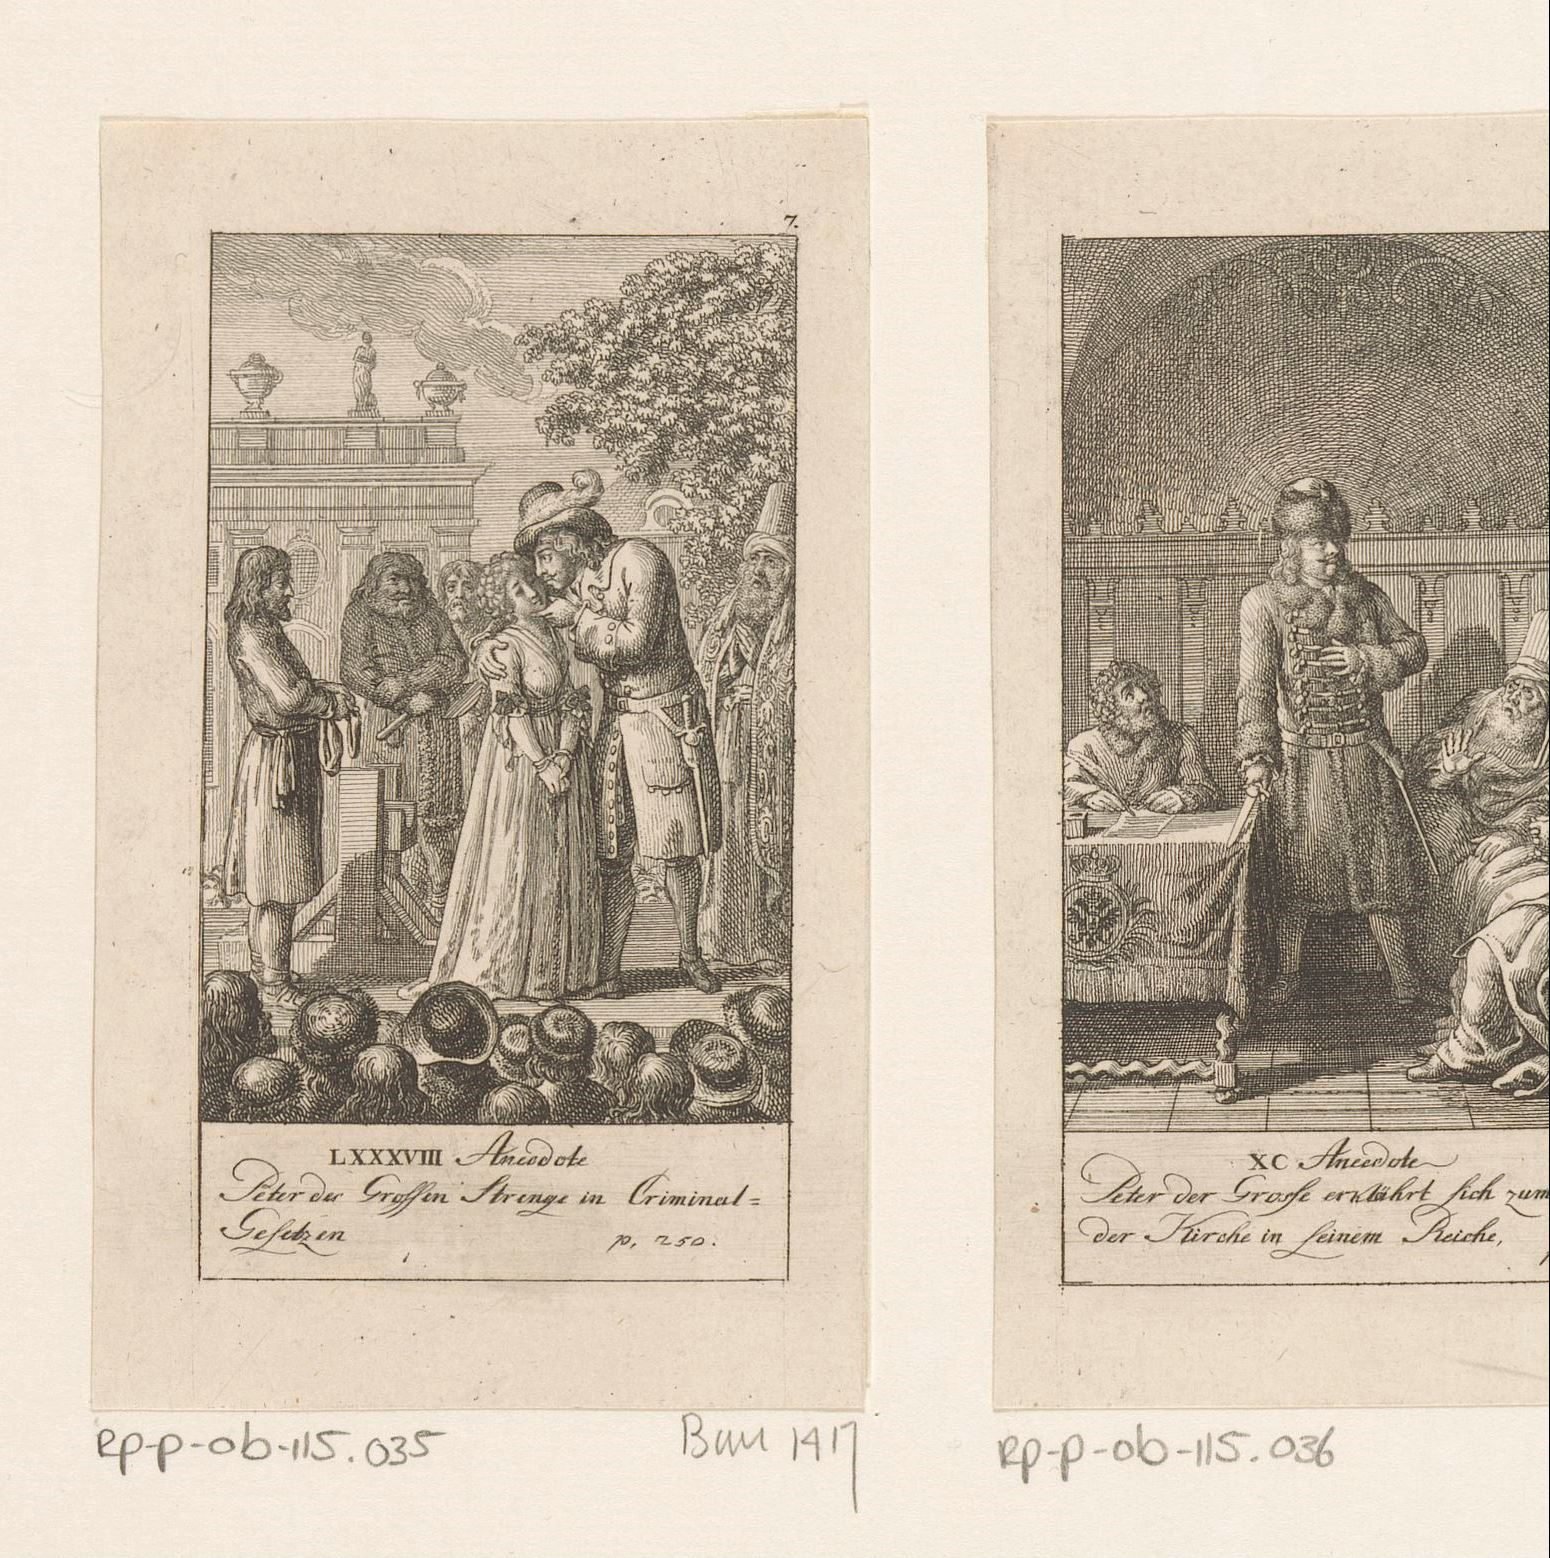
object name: print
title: Peter de Grote kust de ter dood veroordeelde vrouw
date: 1789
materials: paper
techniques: etching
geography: berlin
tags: peter i de grote (tsaar van rusland), history, (lovers) kissing each other, (person under sentence of death) on the way to the scaffold or place of execution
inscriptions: collector's mark: Lugt 2228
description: Vervaardigd voor 'Anekdoten vom Peter dem Grossen'. Prent gebruikt voor: Goettinger Taschen Calender vom Jahr 1790. Göttingen: Johann Christoph Dietrich, [1789].